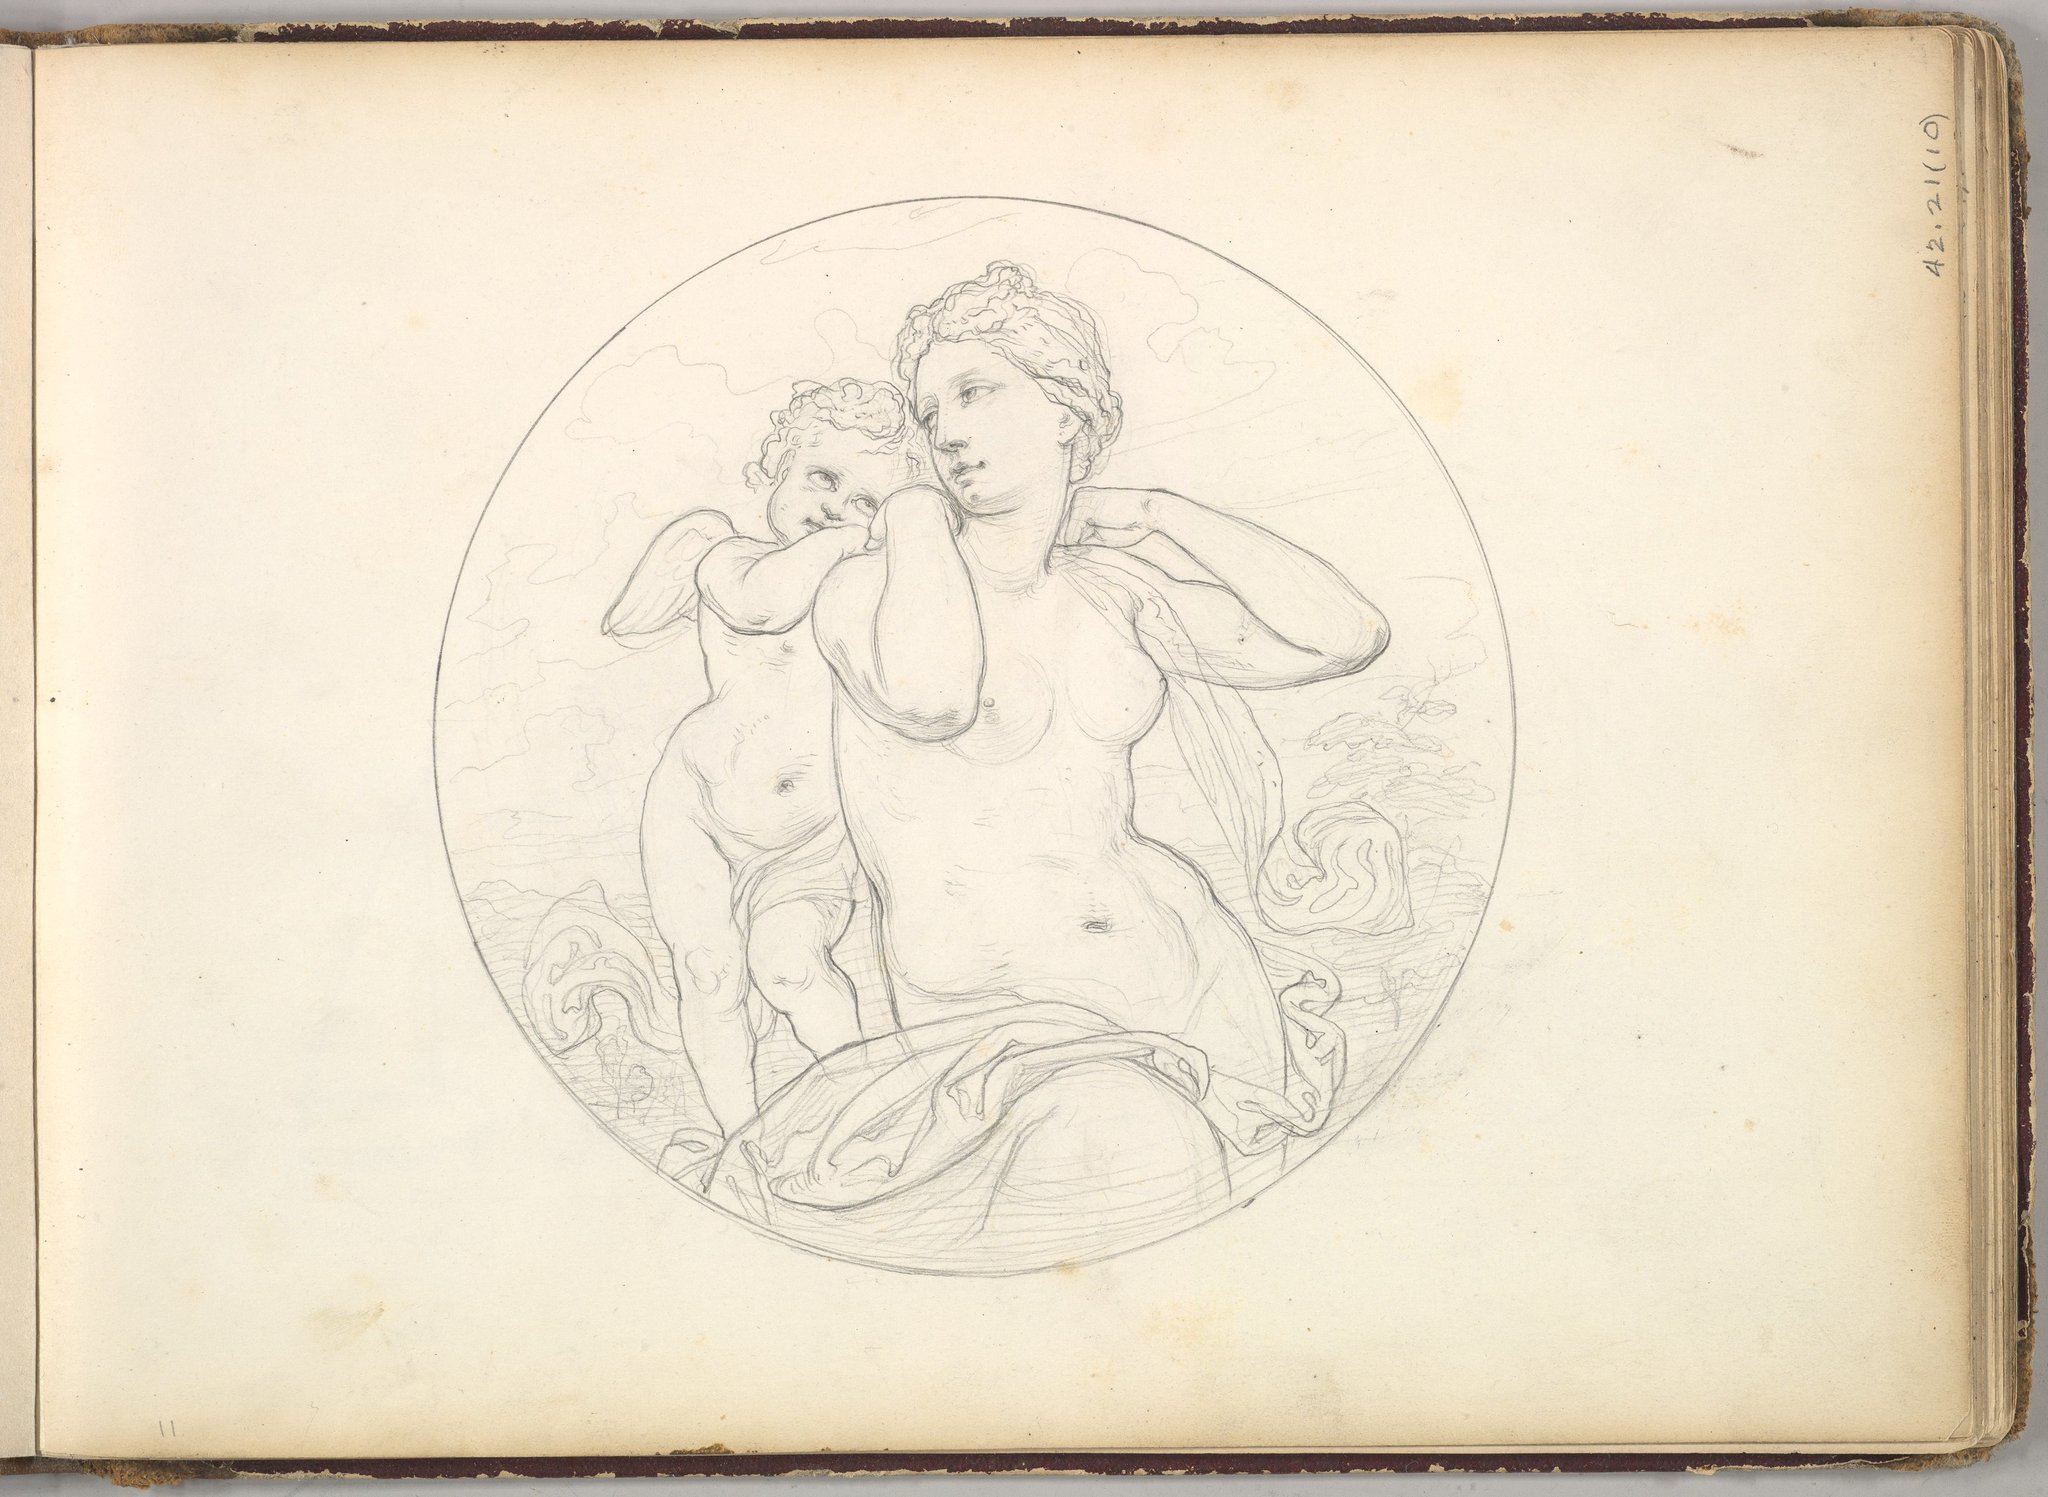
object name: drawing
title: Venus and Cupid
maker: frederic, lord leighton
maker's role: artist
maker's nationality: british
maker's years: 1830-1896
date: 1849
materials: graphite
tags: cupid,venus